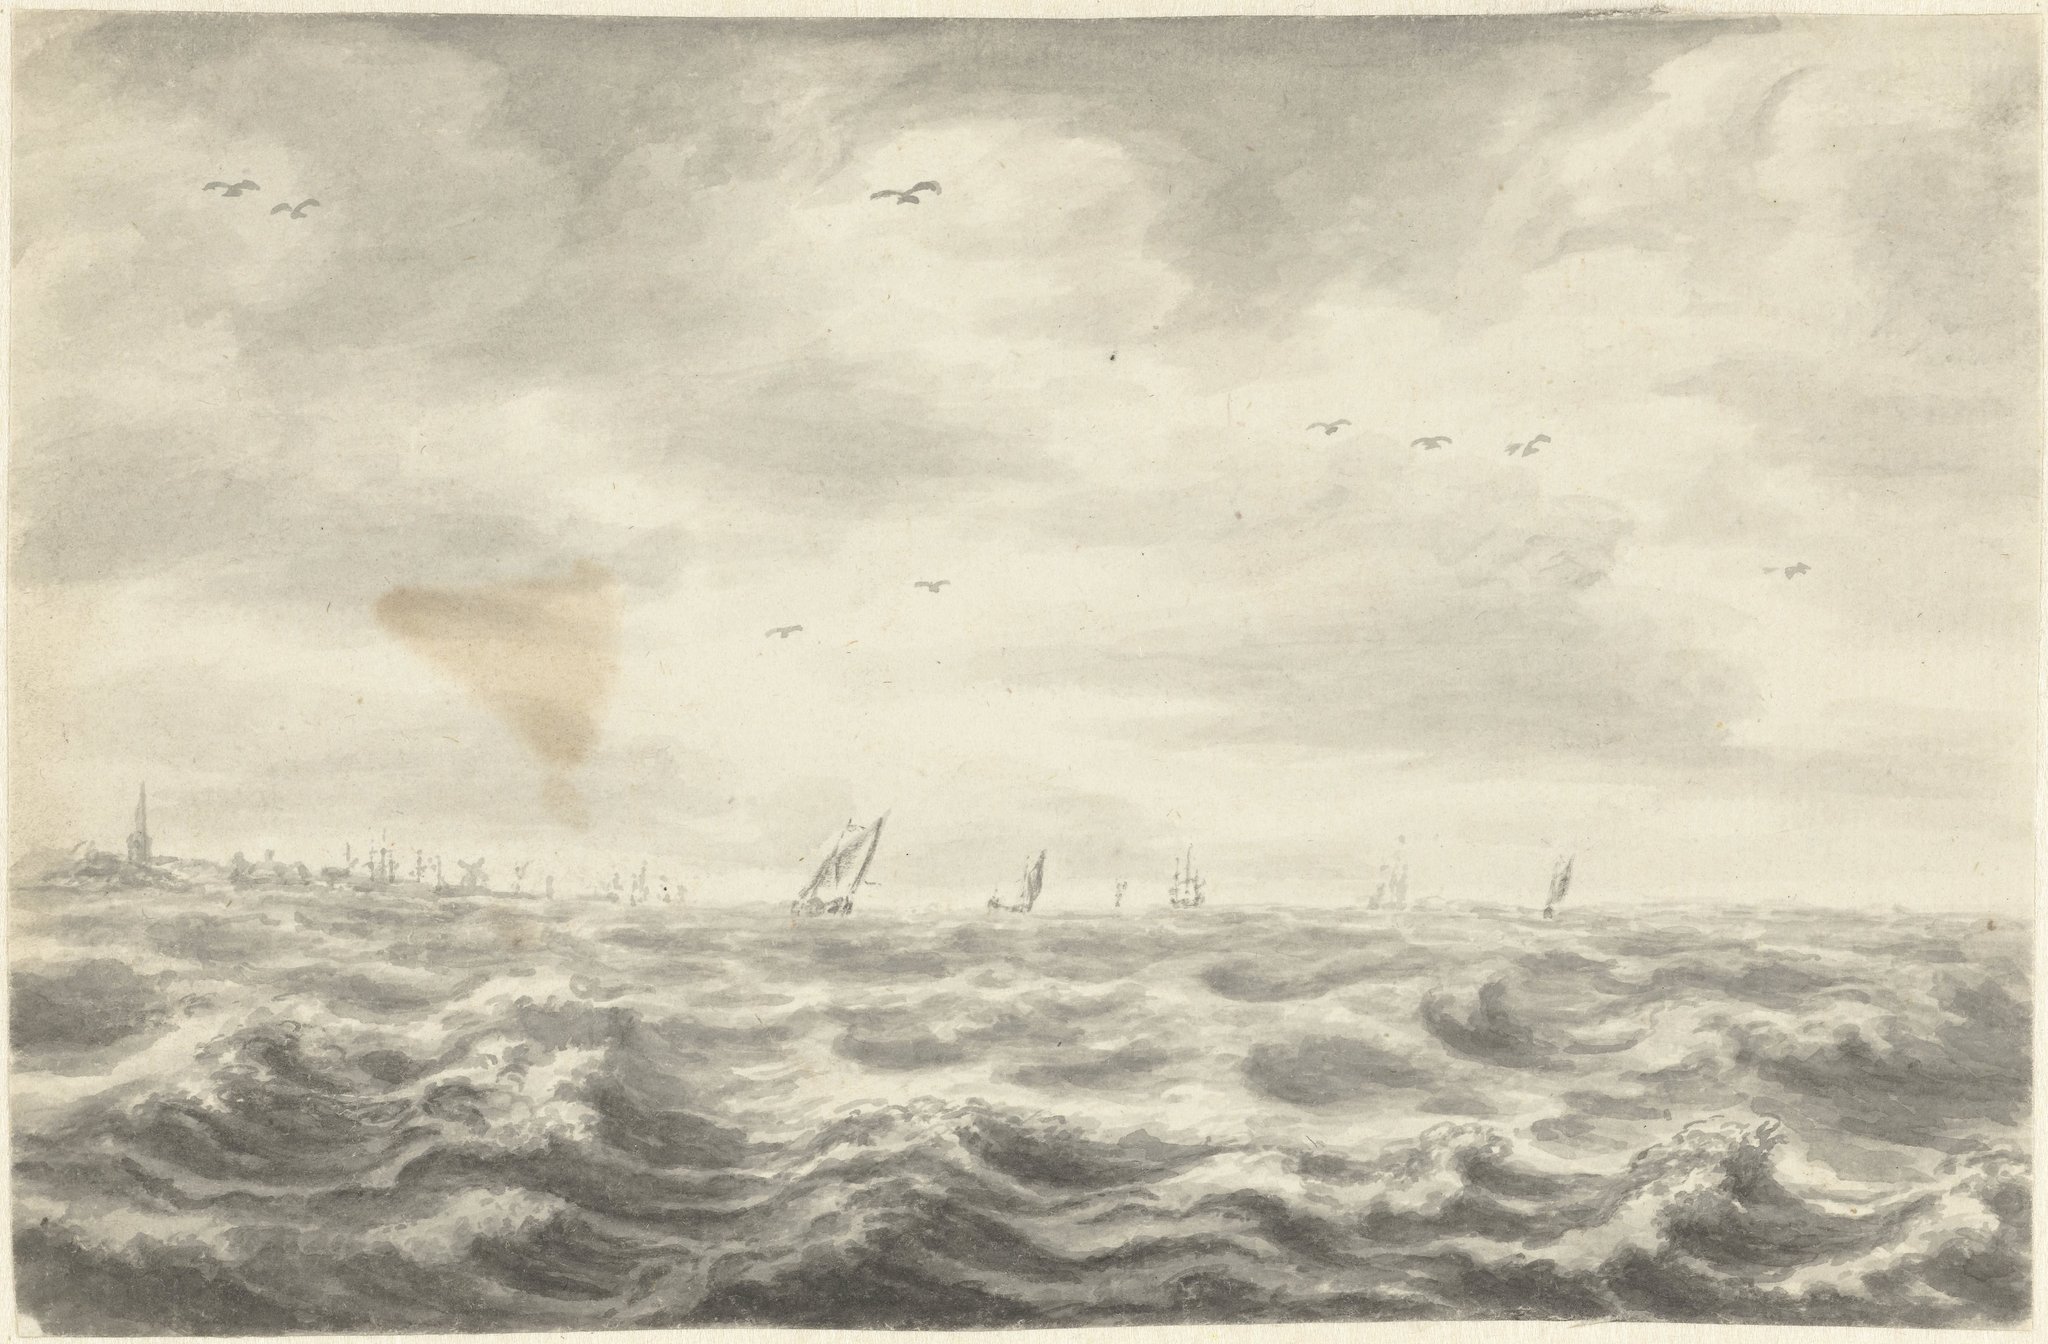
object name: drawing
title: Zeegezicht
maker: pieter idserts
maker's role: draughtsman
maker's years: 1698-1781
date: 1708-1781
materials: paper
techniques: brush